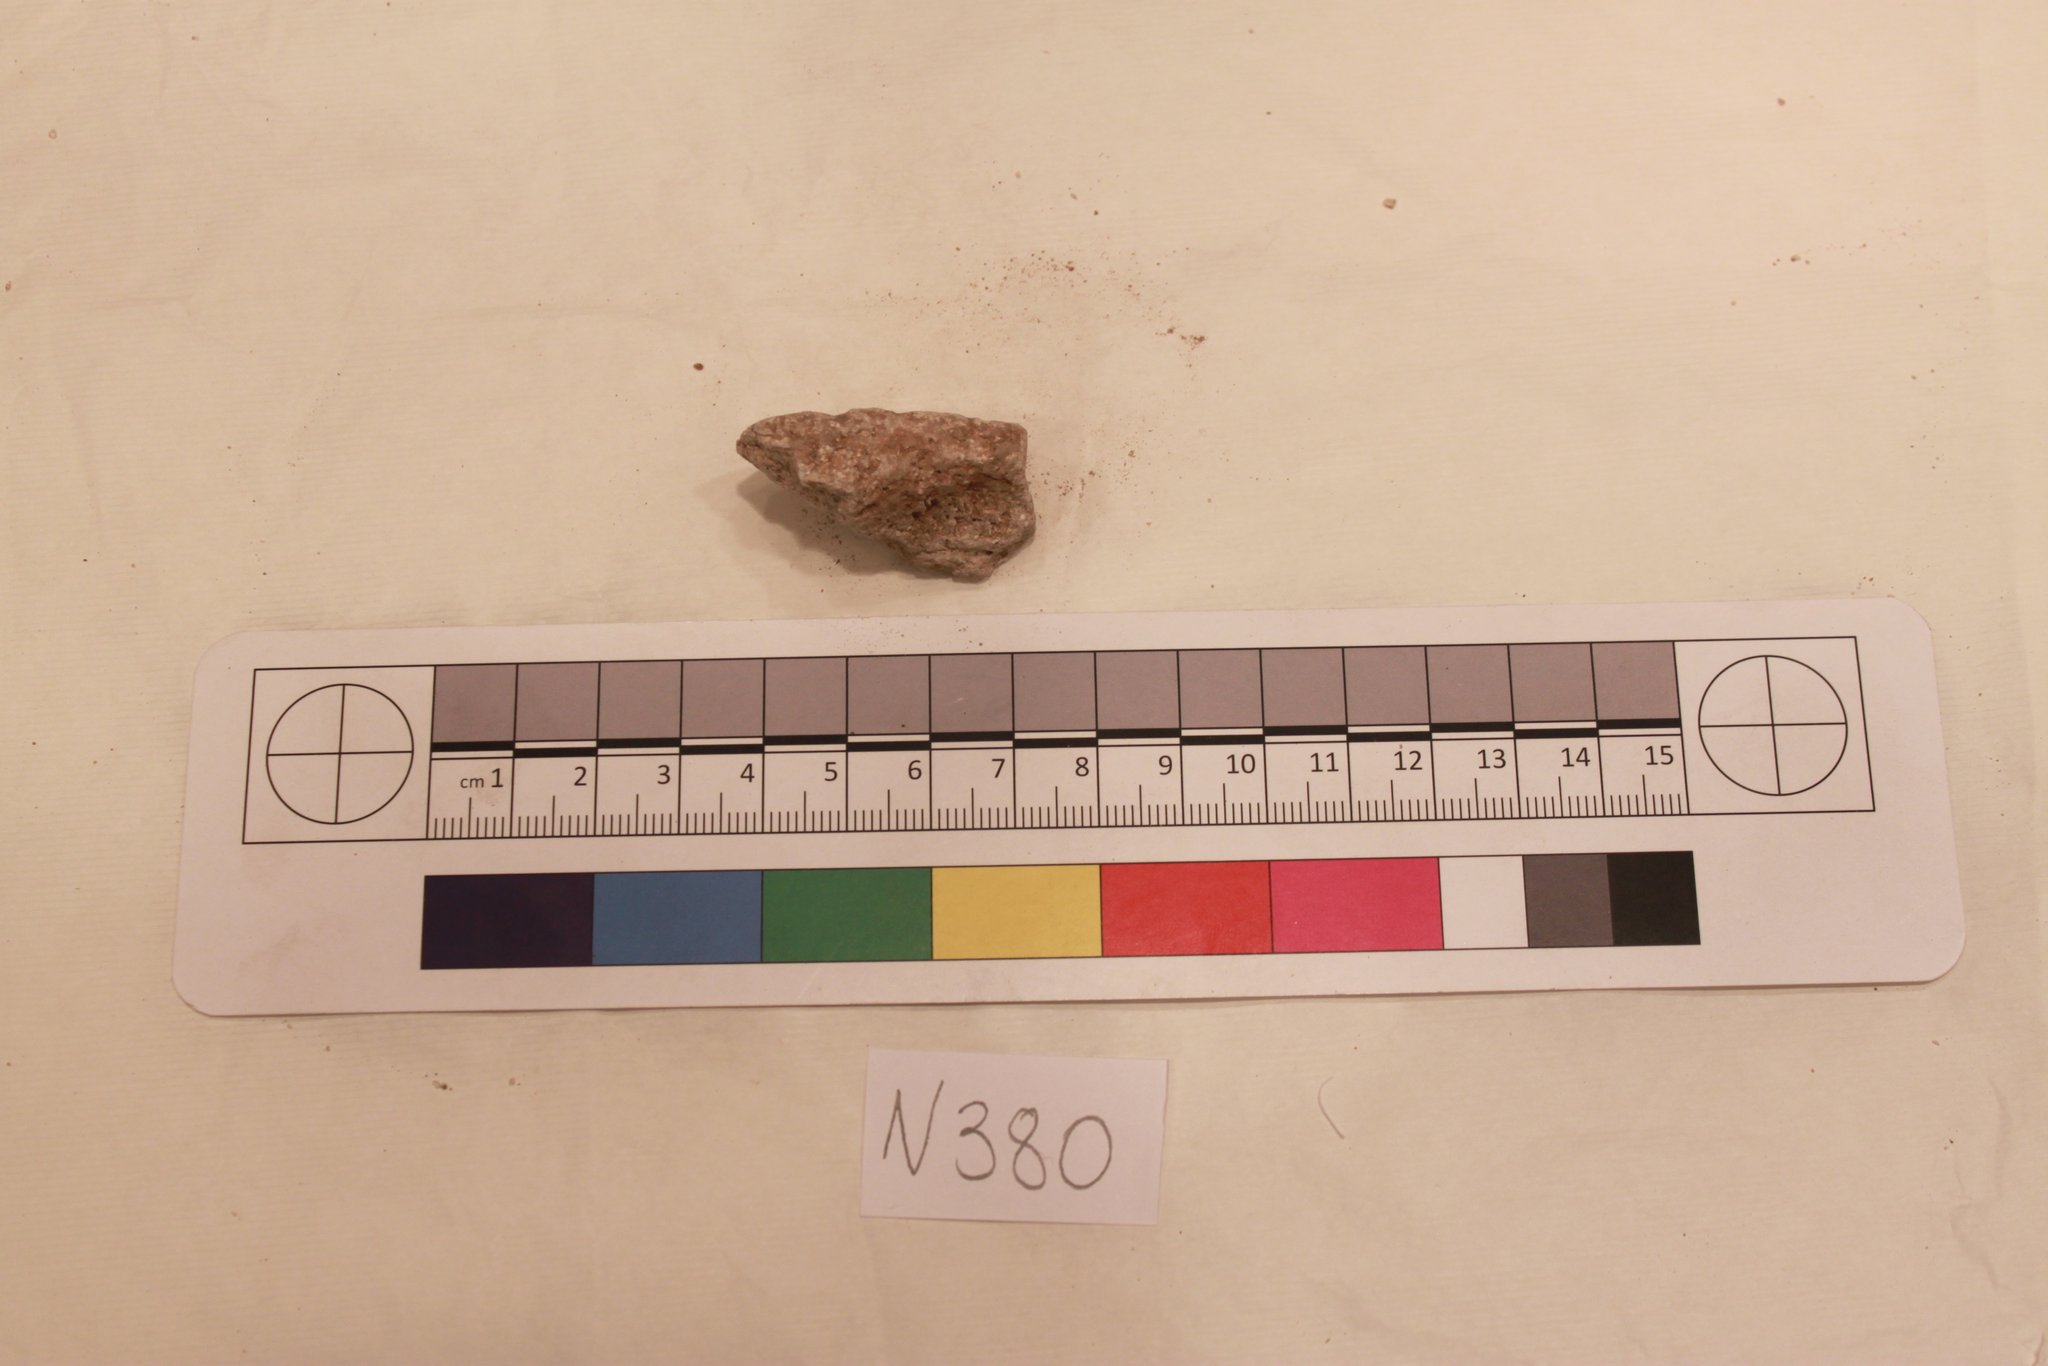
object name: fragment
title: Stucco Fragment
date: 701-1200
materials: plaster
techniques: carving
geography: iran